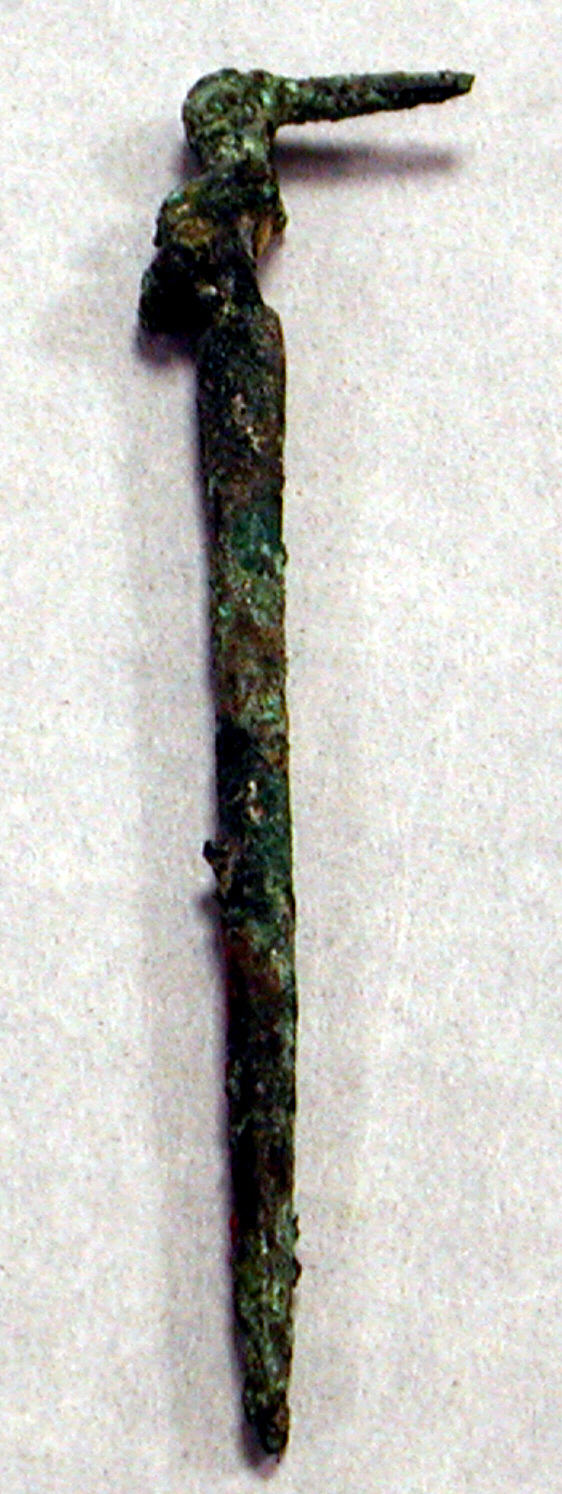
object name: lime spoon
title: Copper Lime Spoon with Bird Top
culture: inca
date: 1401-1600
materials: copper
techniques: casting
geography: peru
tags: birds